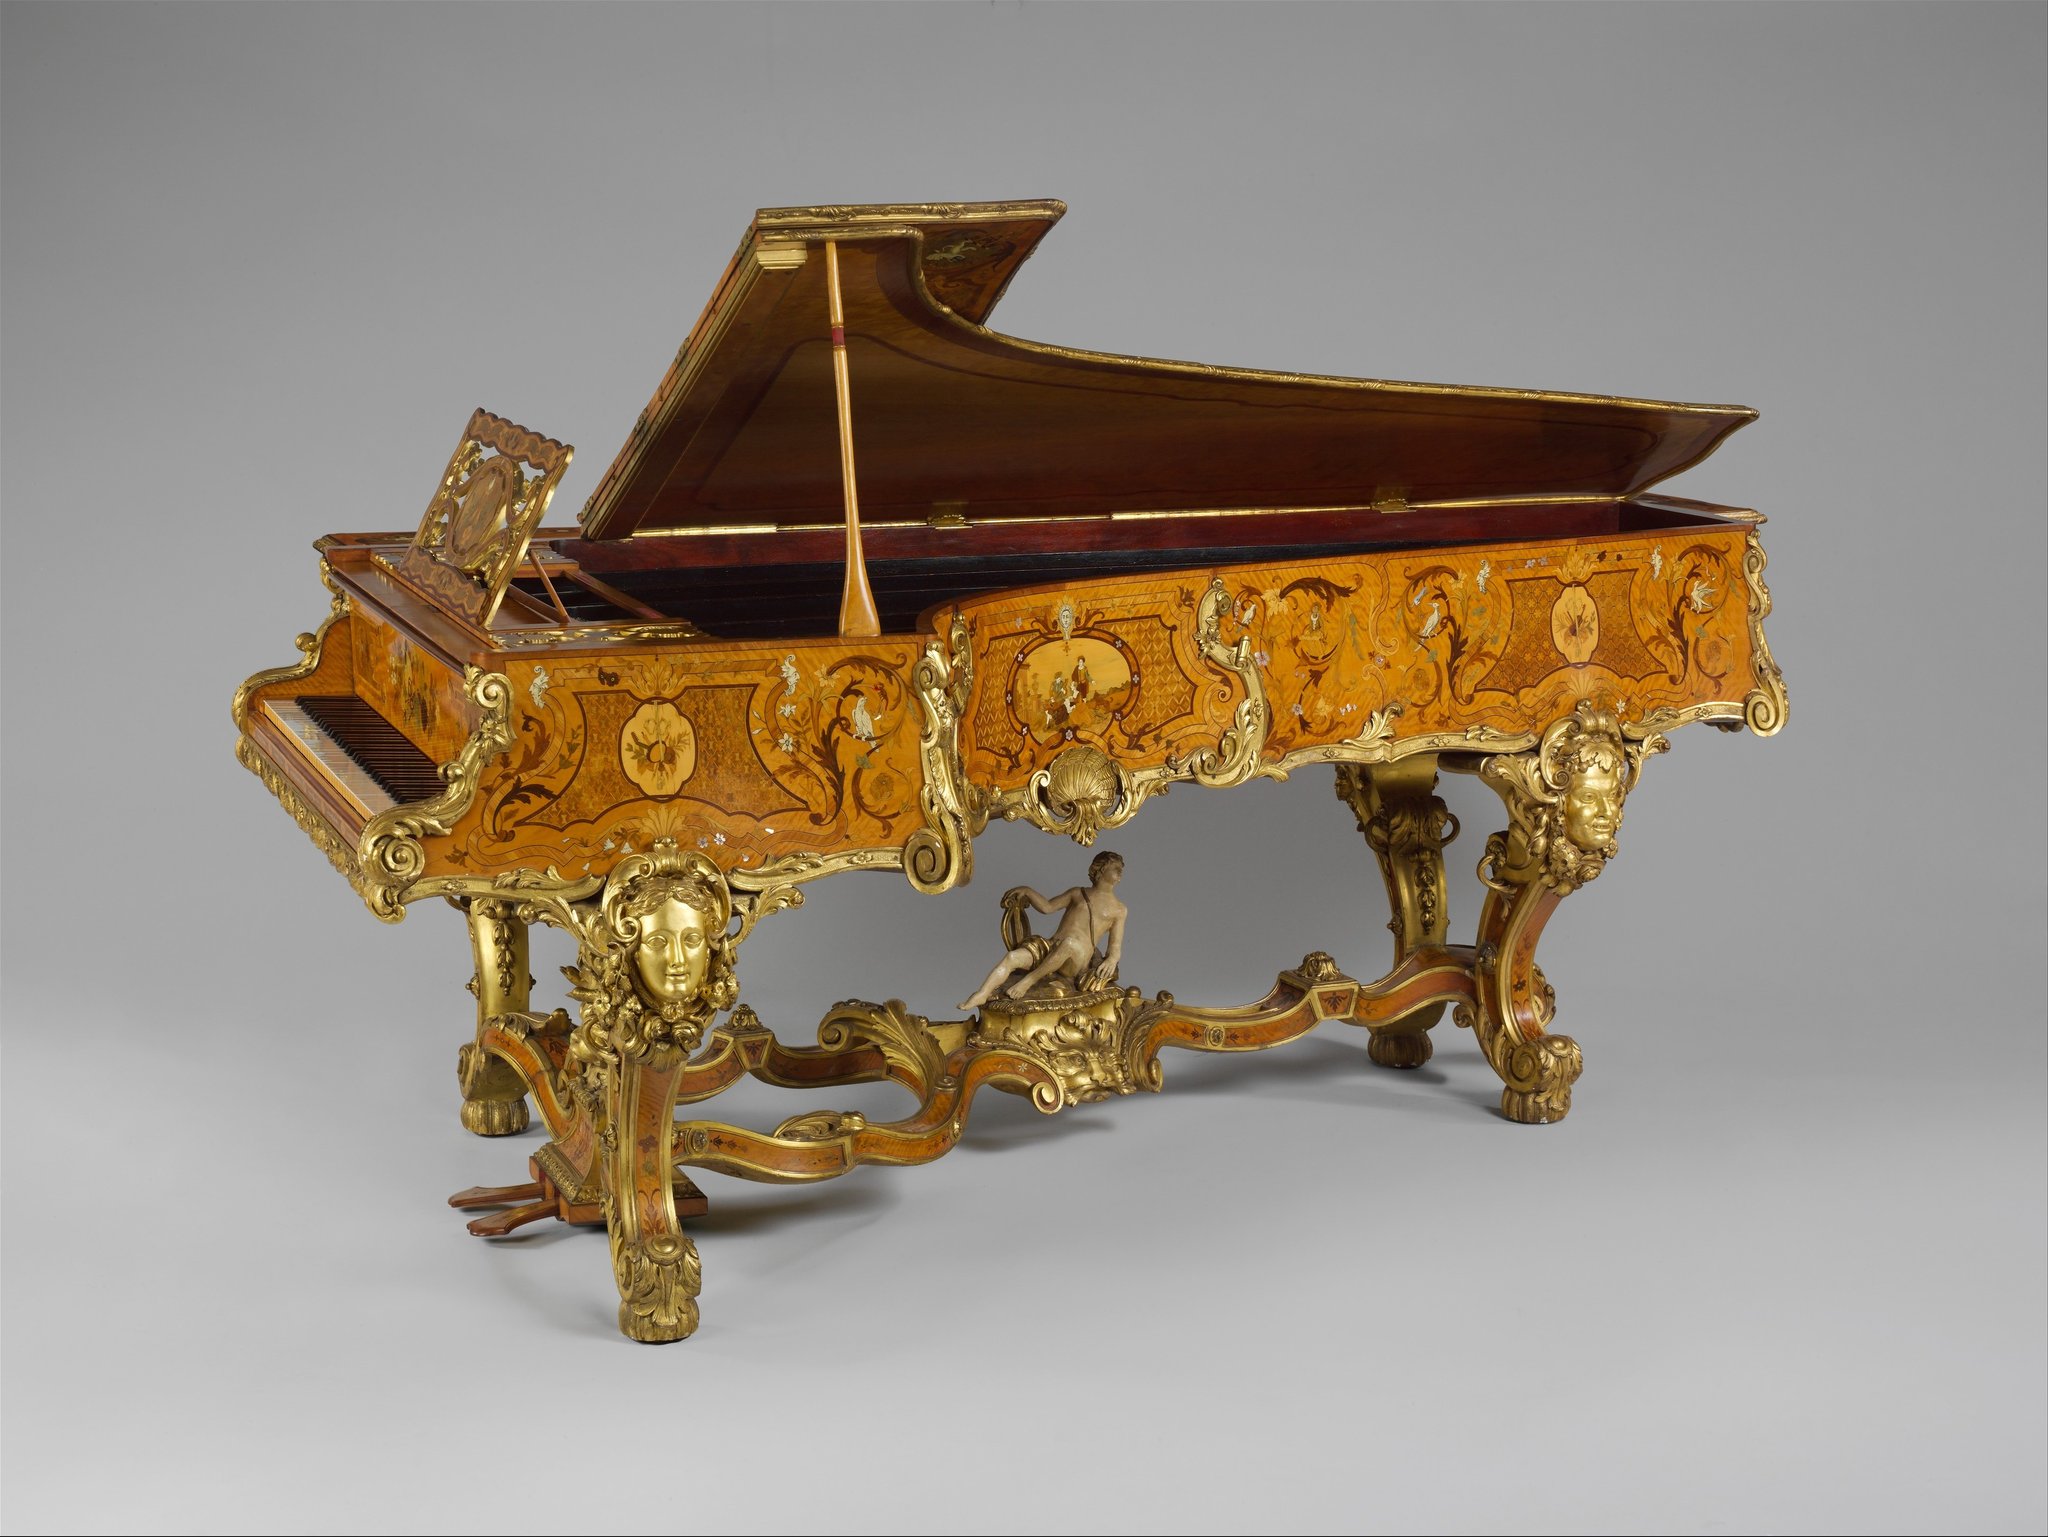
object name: grand piano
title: Grand Pianoforte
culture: british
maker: érard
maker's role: manufacturer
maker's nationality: french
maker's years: 1780-1959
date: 1840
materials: wood, iron, ivory, mother of pearl, silver, steel, metal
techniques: gilding, veneering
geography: united kingdom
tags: birds,men,women,bacchus,ceres,persephone